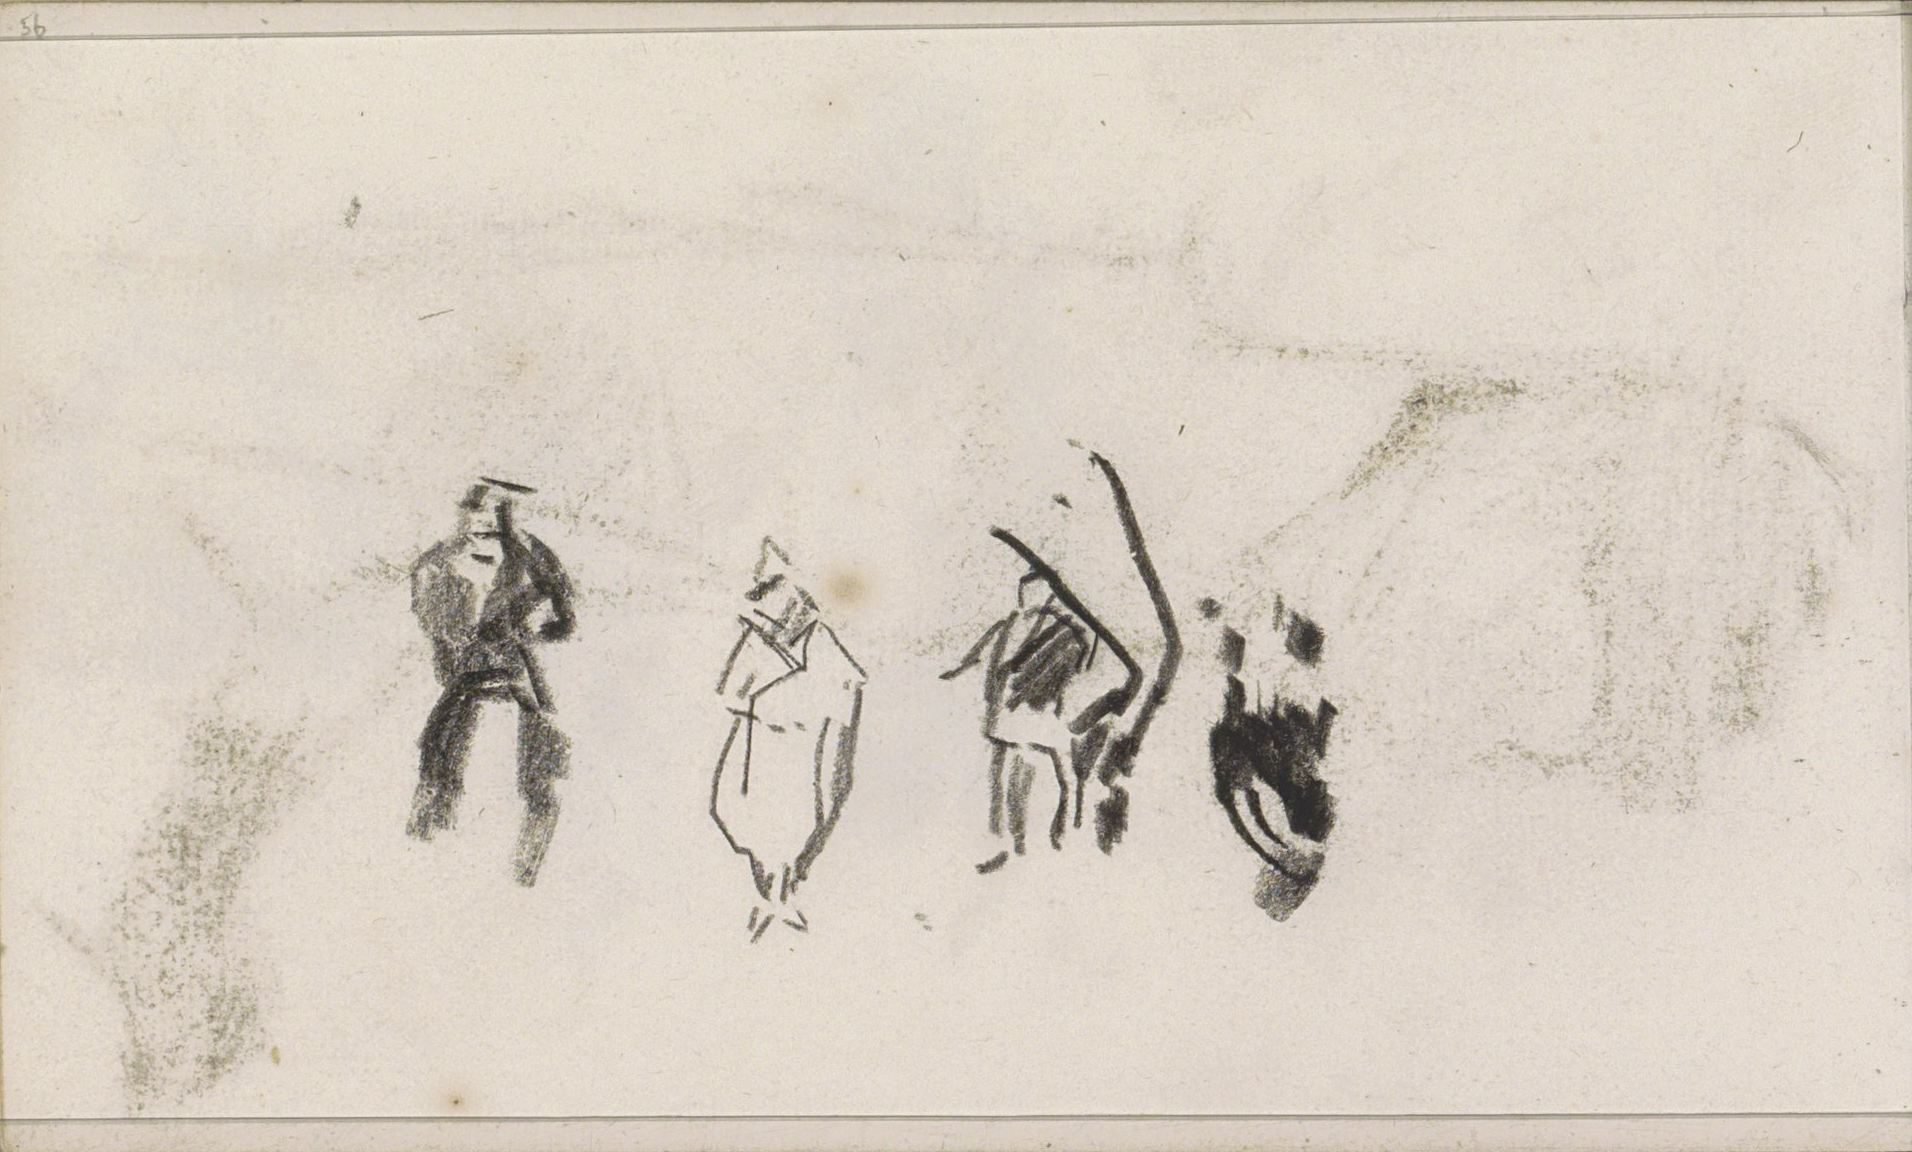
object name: sketchbook leaf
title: Staande figuren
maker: isaac israels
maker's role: draughtsman, painter, print maker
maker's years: 1865-1934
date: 1875-1934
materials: chalk, paper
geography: the hague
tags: adult woman (+ standing), adult man (+ standing)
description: Pagina 56 uit schetsboek XLVIII met 62 pagina's.